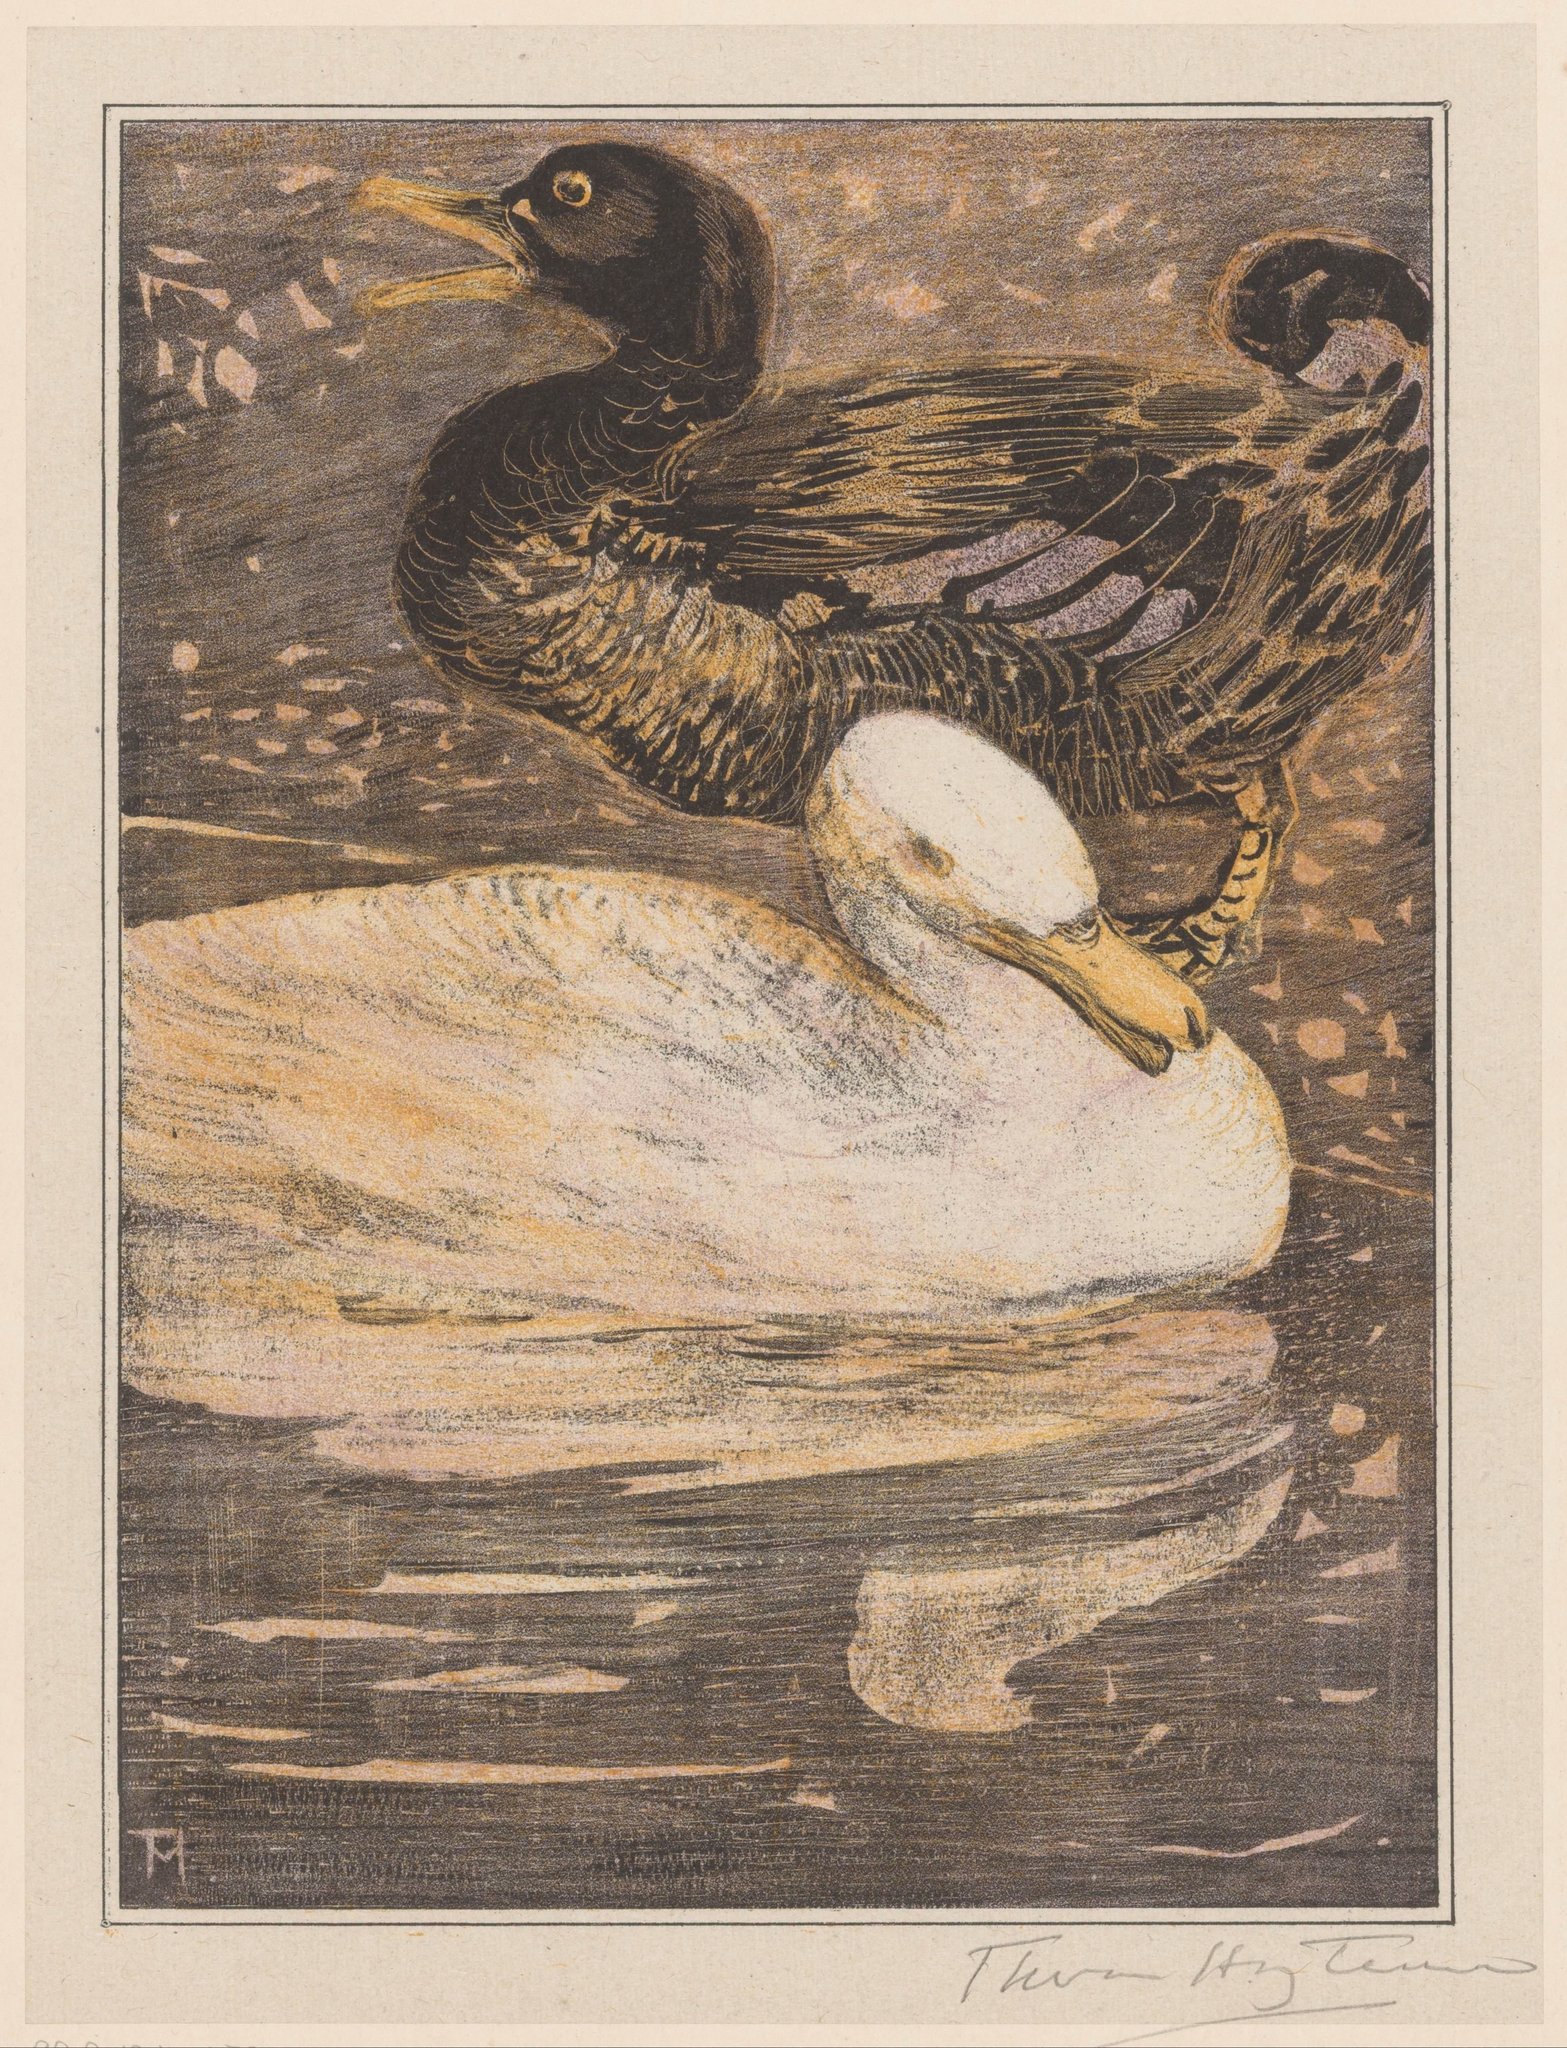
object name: print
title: Twee eenden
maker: theo van hoytema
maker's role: draughtsman, painter, print maker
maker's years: 1863-1917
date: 1878-1907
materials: paper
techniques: lithograph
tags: water-birds: duck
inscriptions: collector's mark: Lugt 2233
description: Een witte eend zwemt in het water. Daarachter een zwarte eend op de kant.